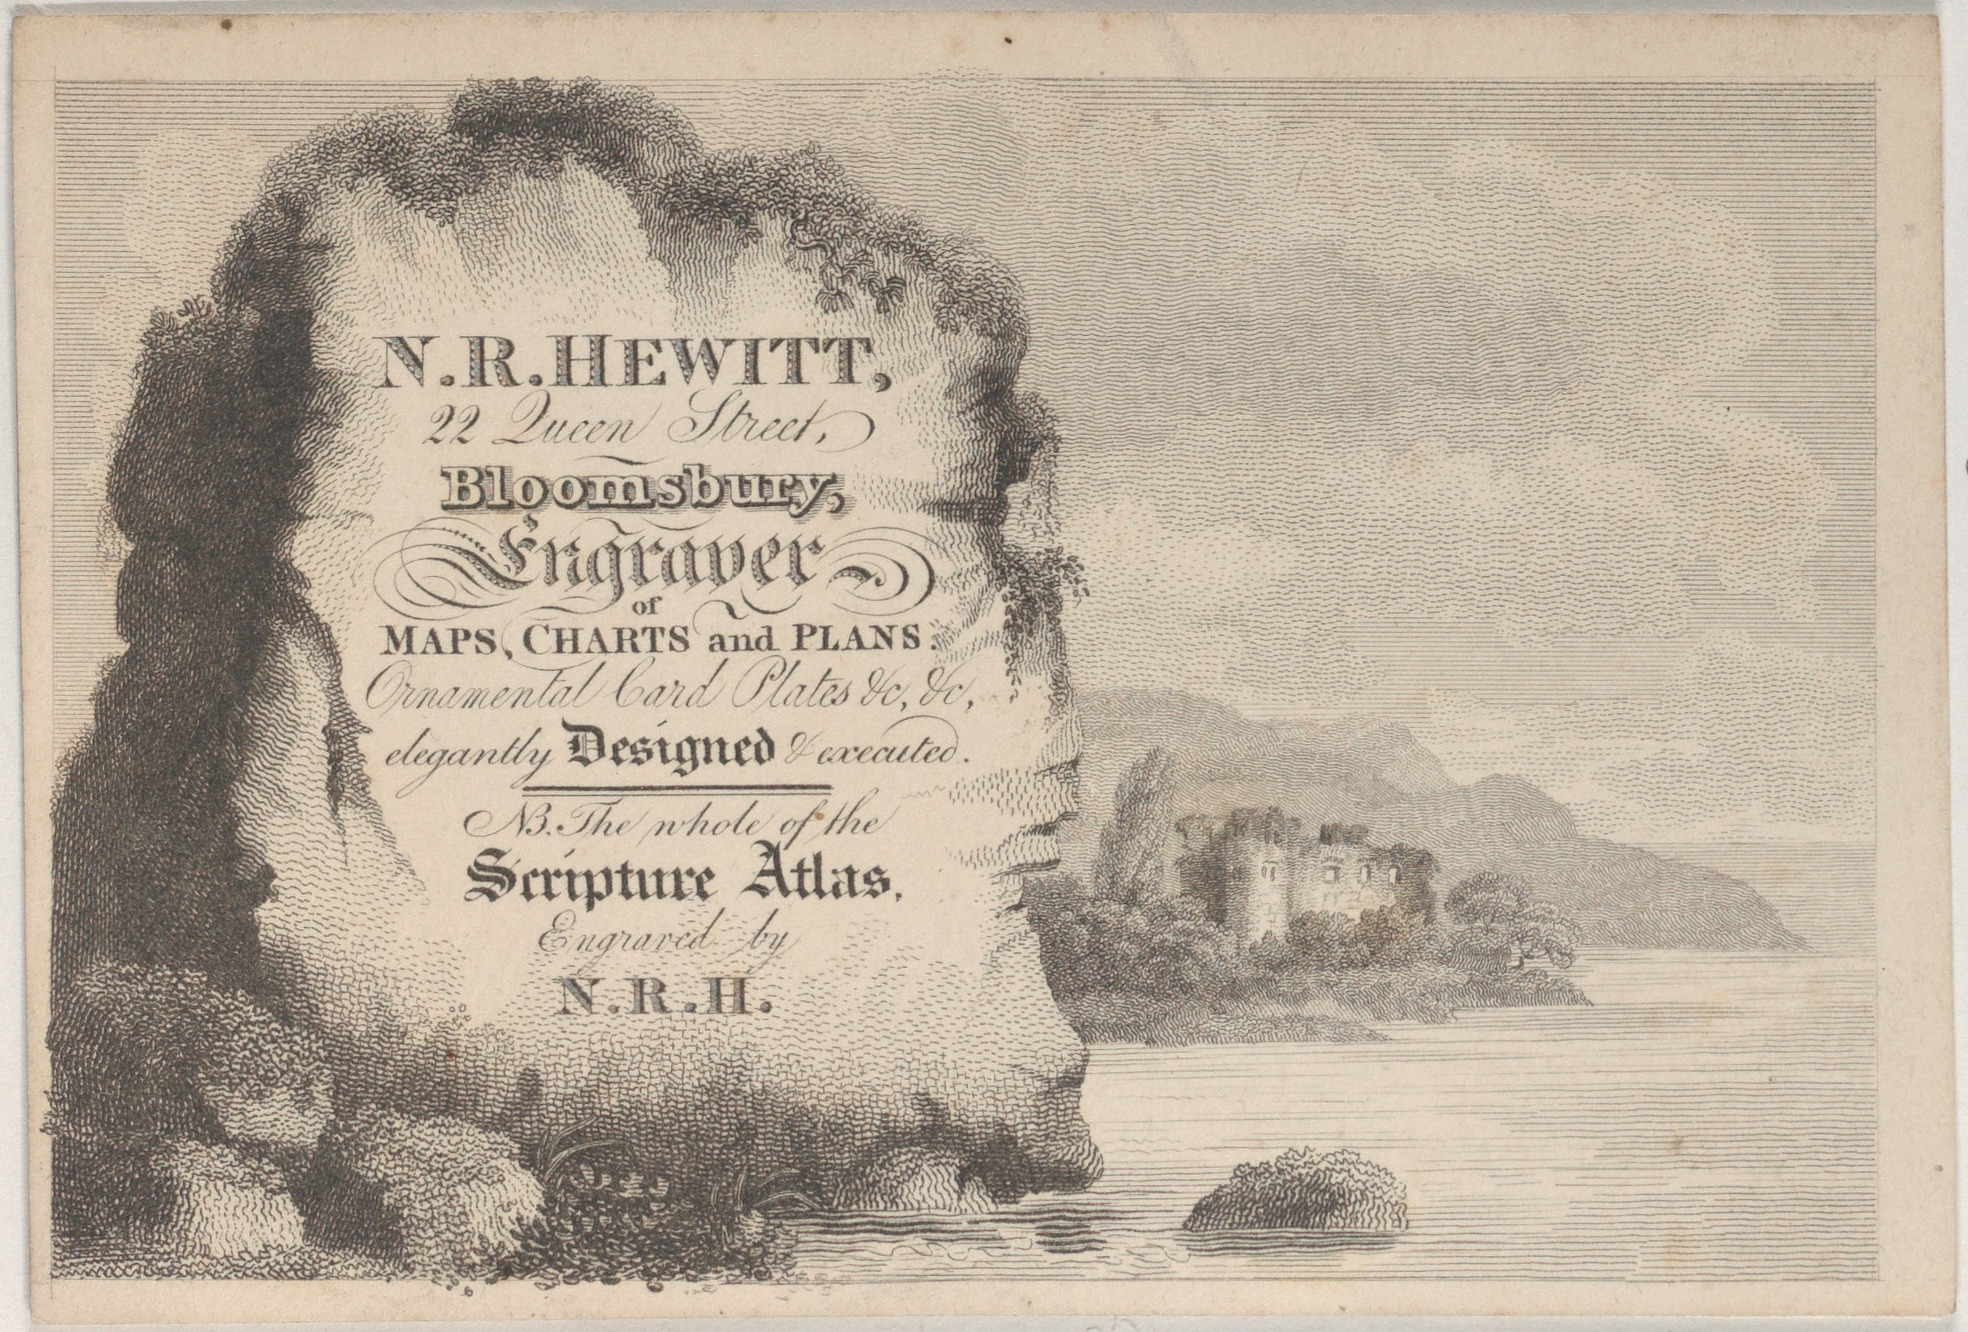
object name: print, trade card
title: Trade Card for N. R. Hewitt, Engraver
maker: anonymous, british, 19th century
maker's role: artist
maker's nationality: british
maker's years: 1800-1900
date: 1801-1900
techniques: engraving